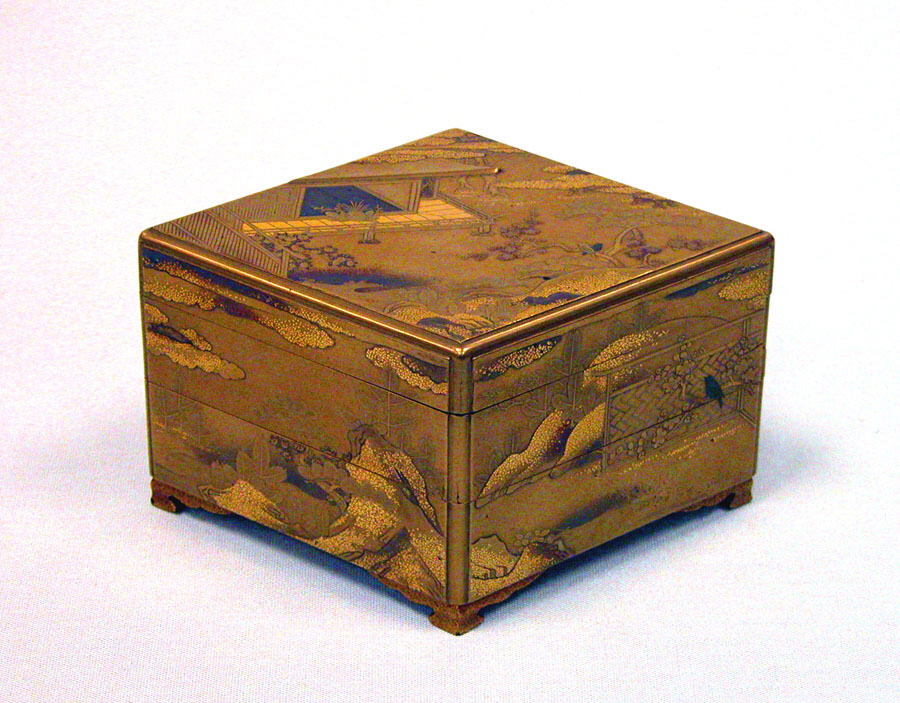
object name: kobako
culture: japanese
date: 1701-1800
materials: gold, lacquer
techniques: maki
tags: landscapes